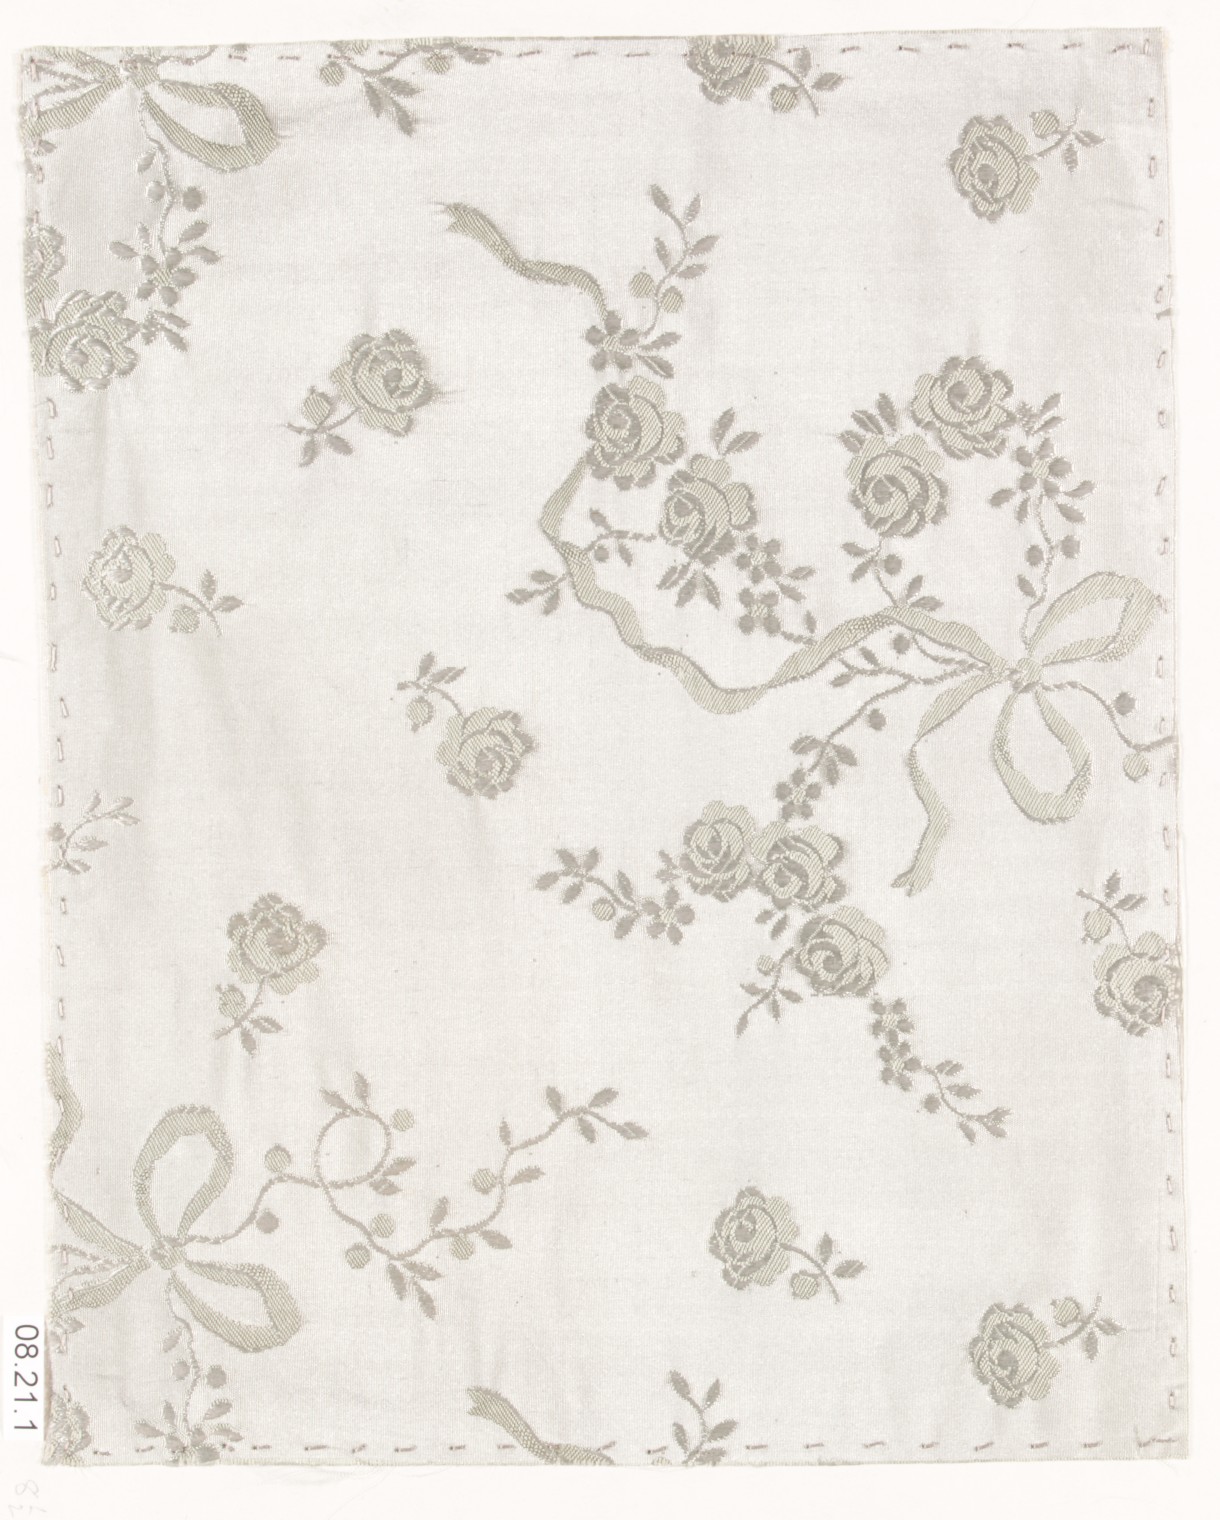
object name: textile sample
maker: Anonymous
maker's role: designer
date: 1900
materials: silk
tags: flowers